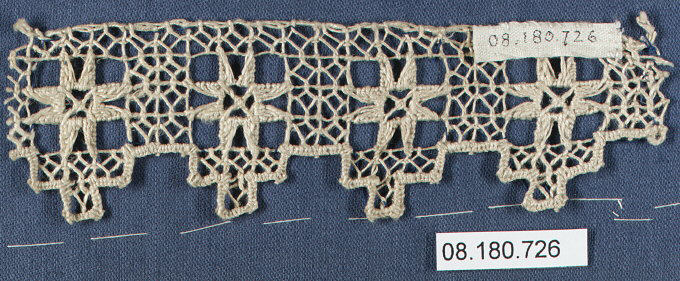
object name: fragment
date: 1801-1900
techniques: embroidery